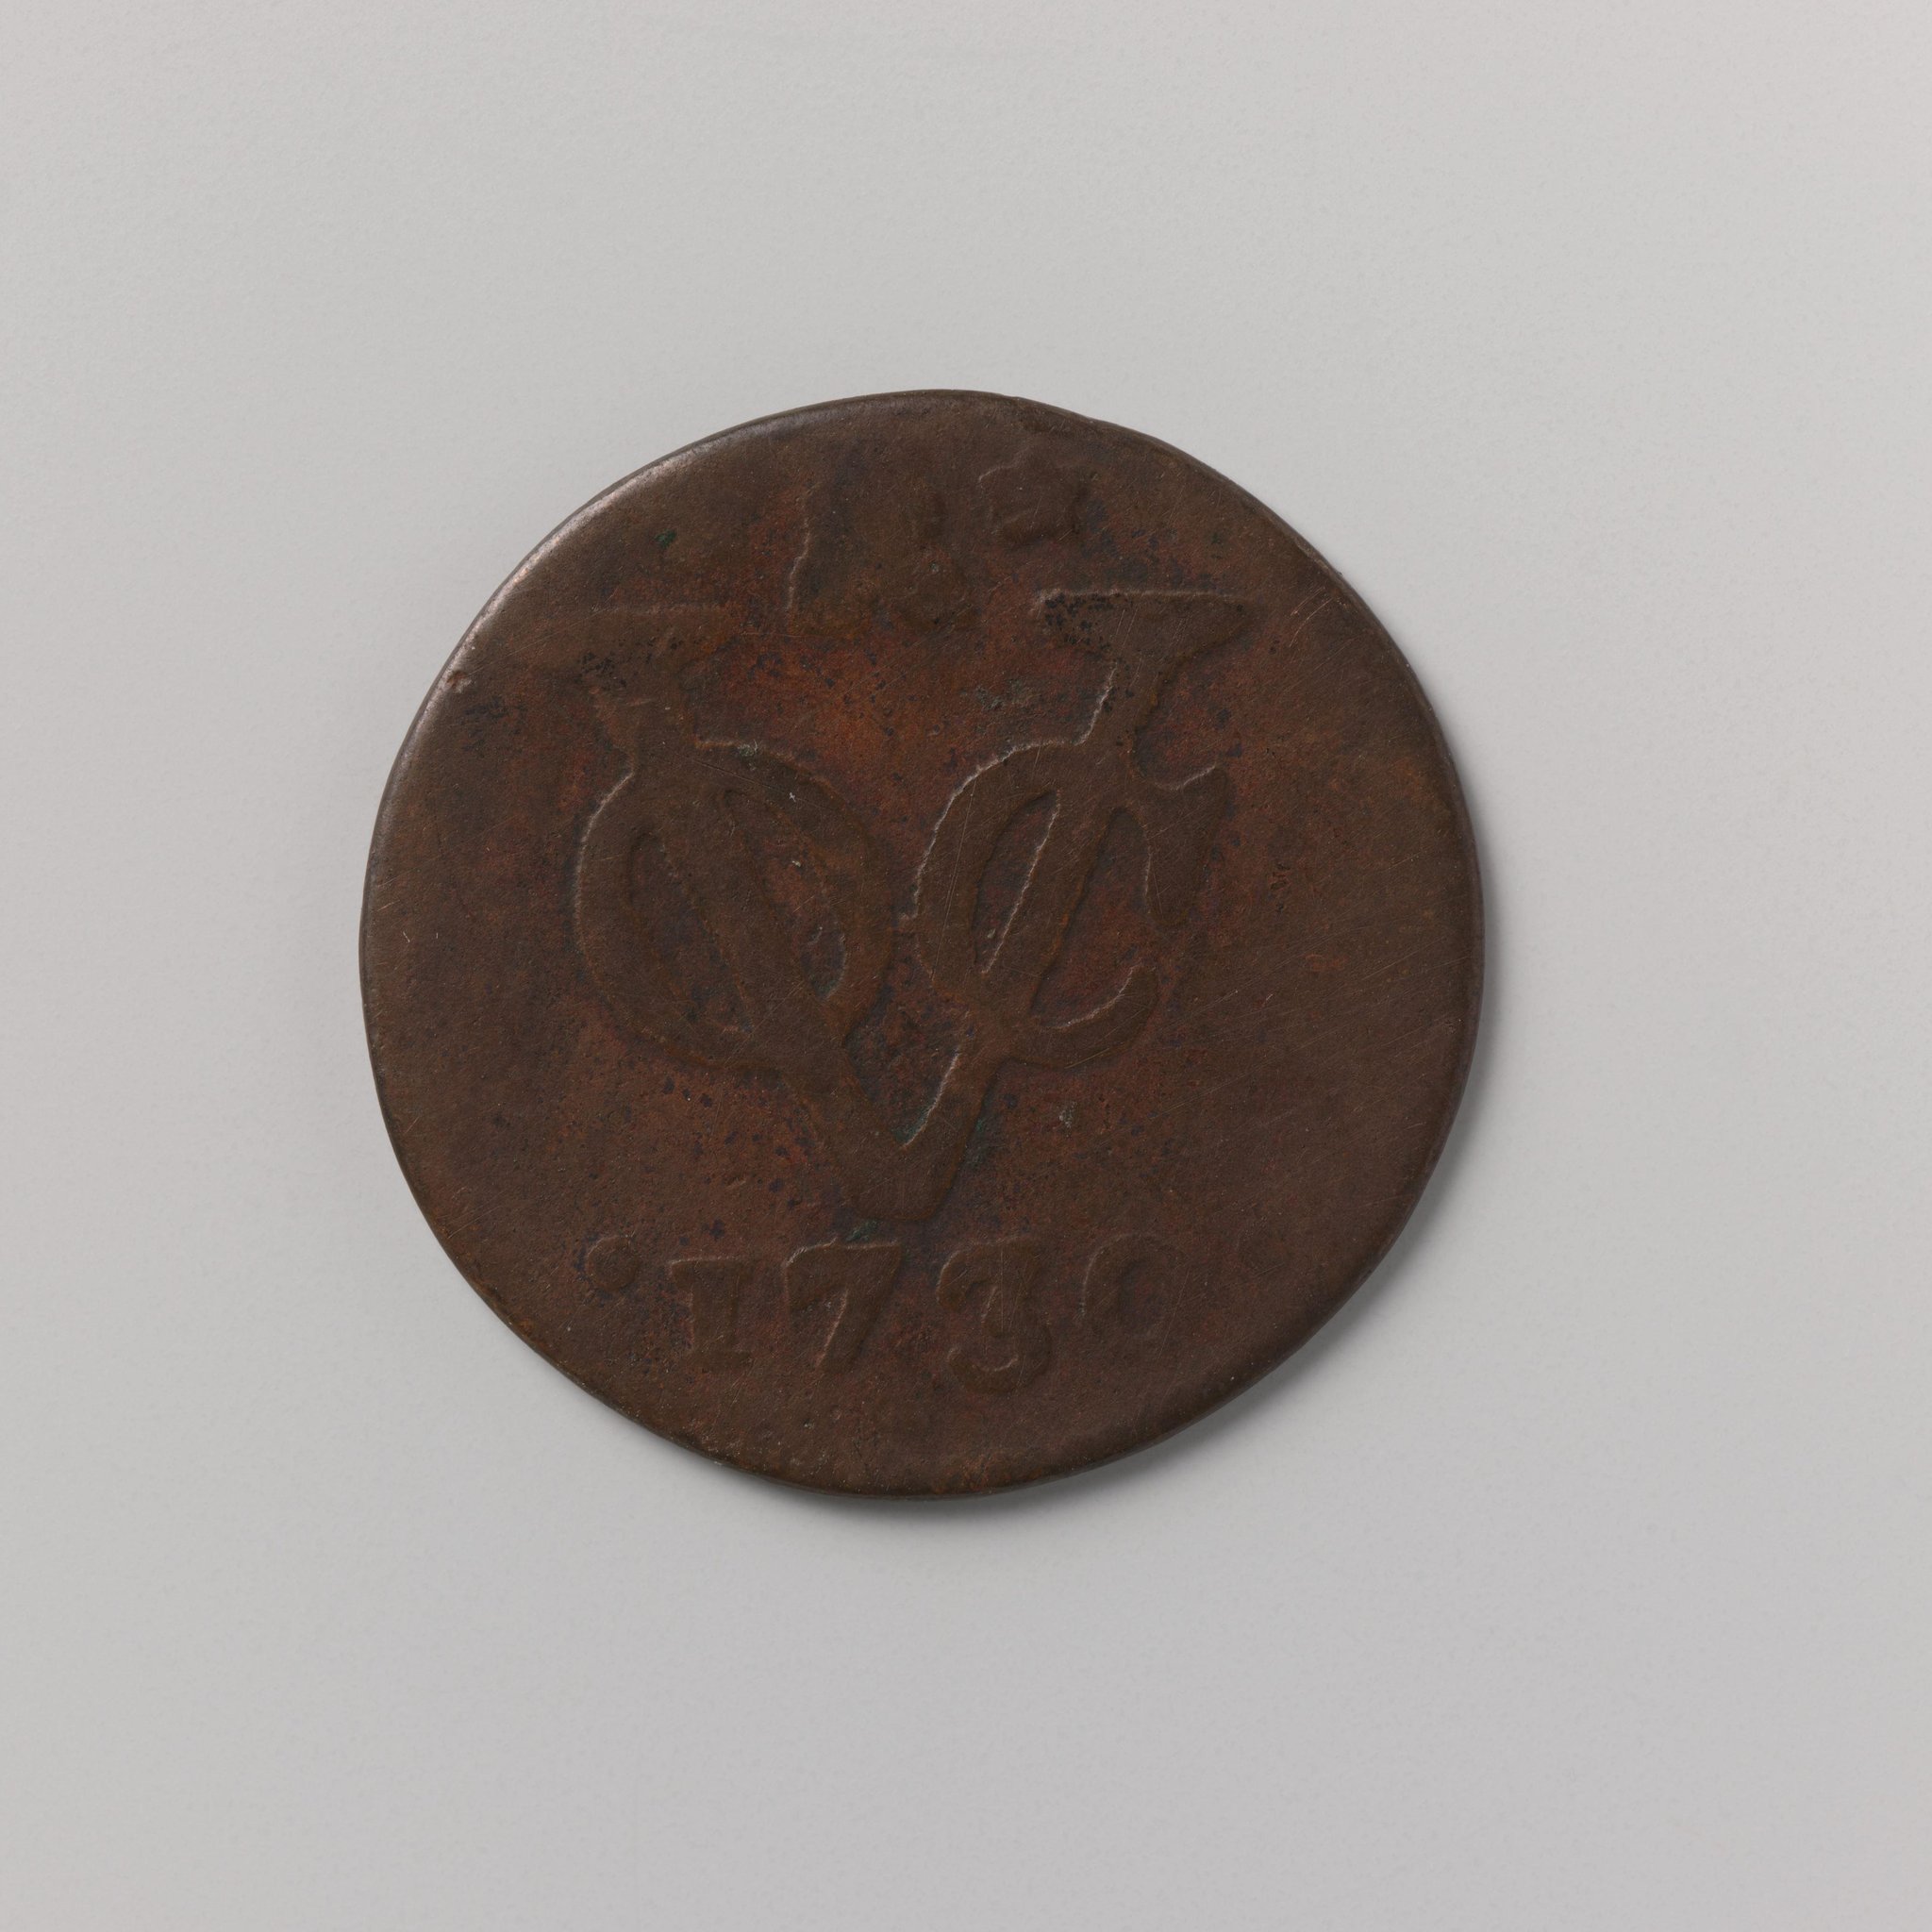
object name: coin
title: VOC, duit Zeeland, 1730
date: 1730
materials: copper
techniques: striking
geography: middelburg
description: Koperen munt. Voorzijde: gekroond wapenschild van Zeeland. Keerzijde: monogram van de VOC, waarboven muntteken en waaronder jaartal. Gladde rand.